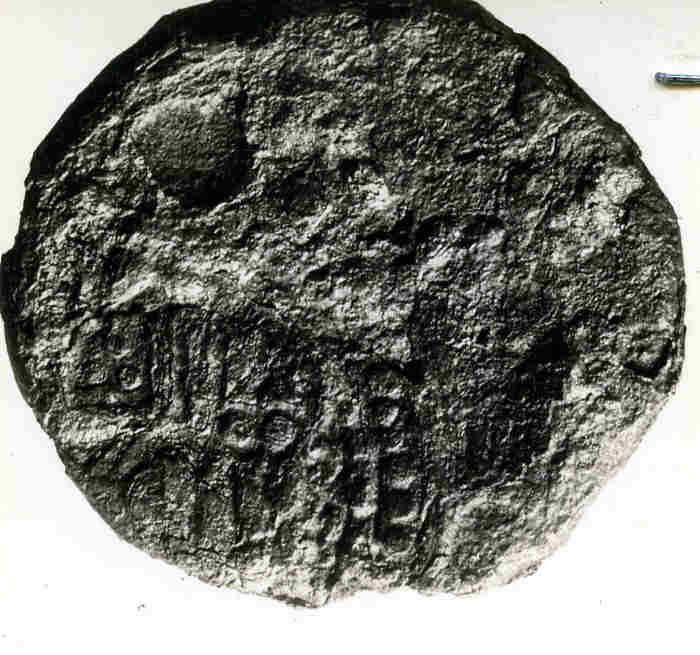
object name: coin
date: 1256-1335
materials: copper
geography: iran